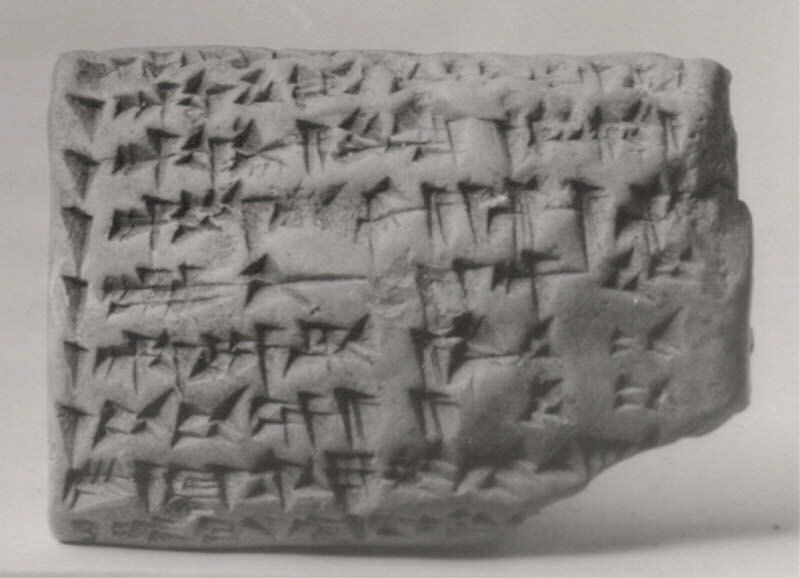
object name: cuneiform tablet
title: Cuneiform tablet: list of witnesses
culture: assyrian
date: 634 BCE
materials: clay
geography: mesopotamia